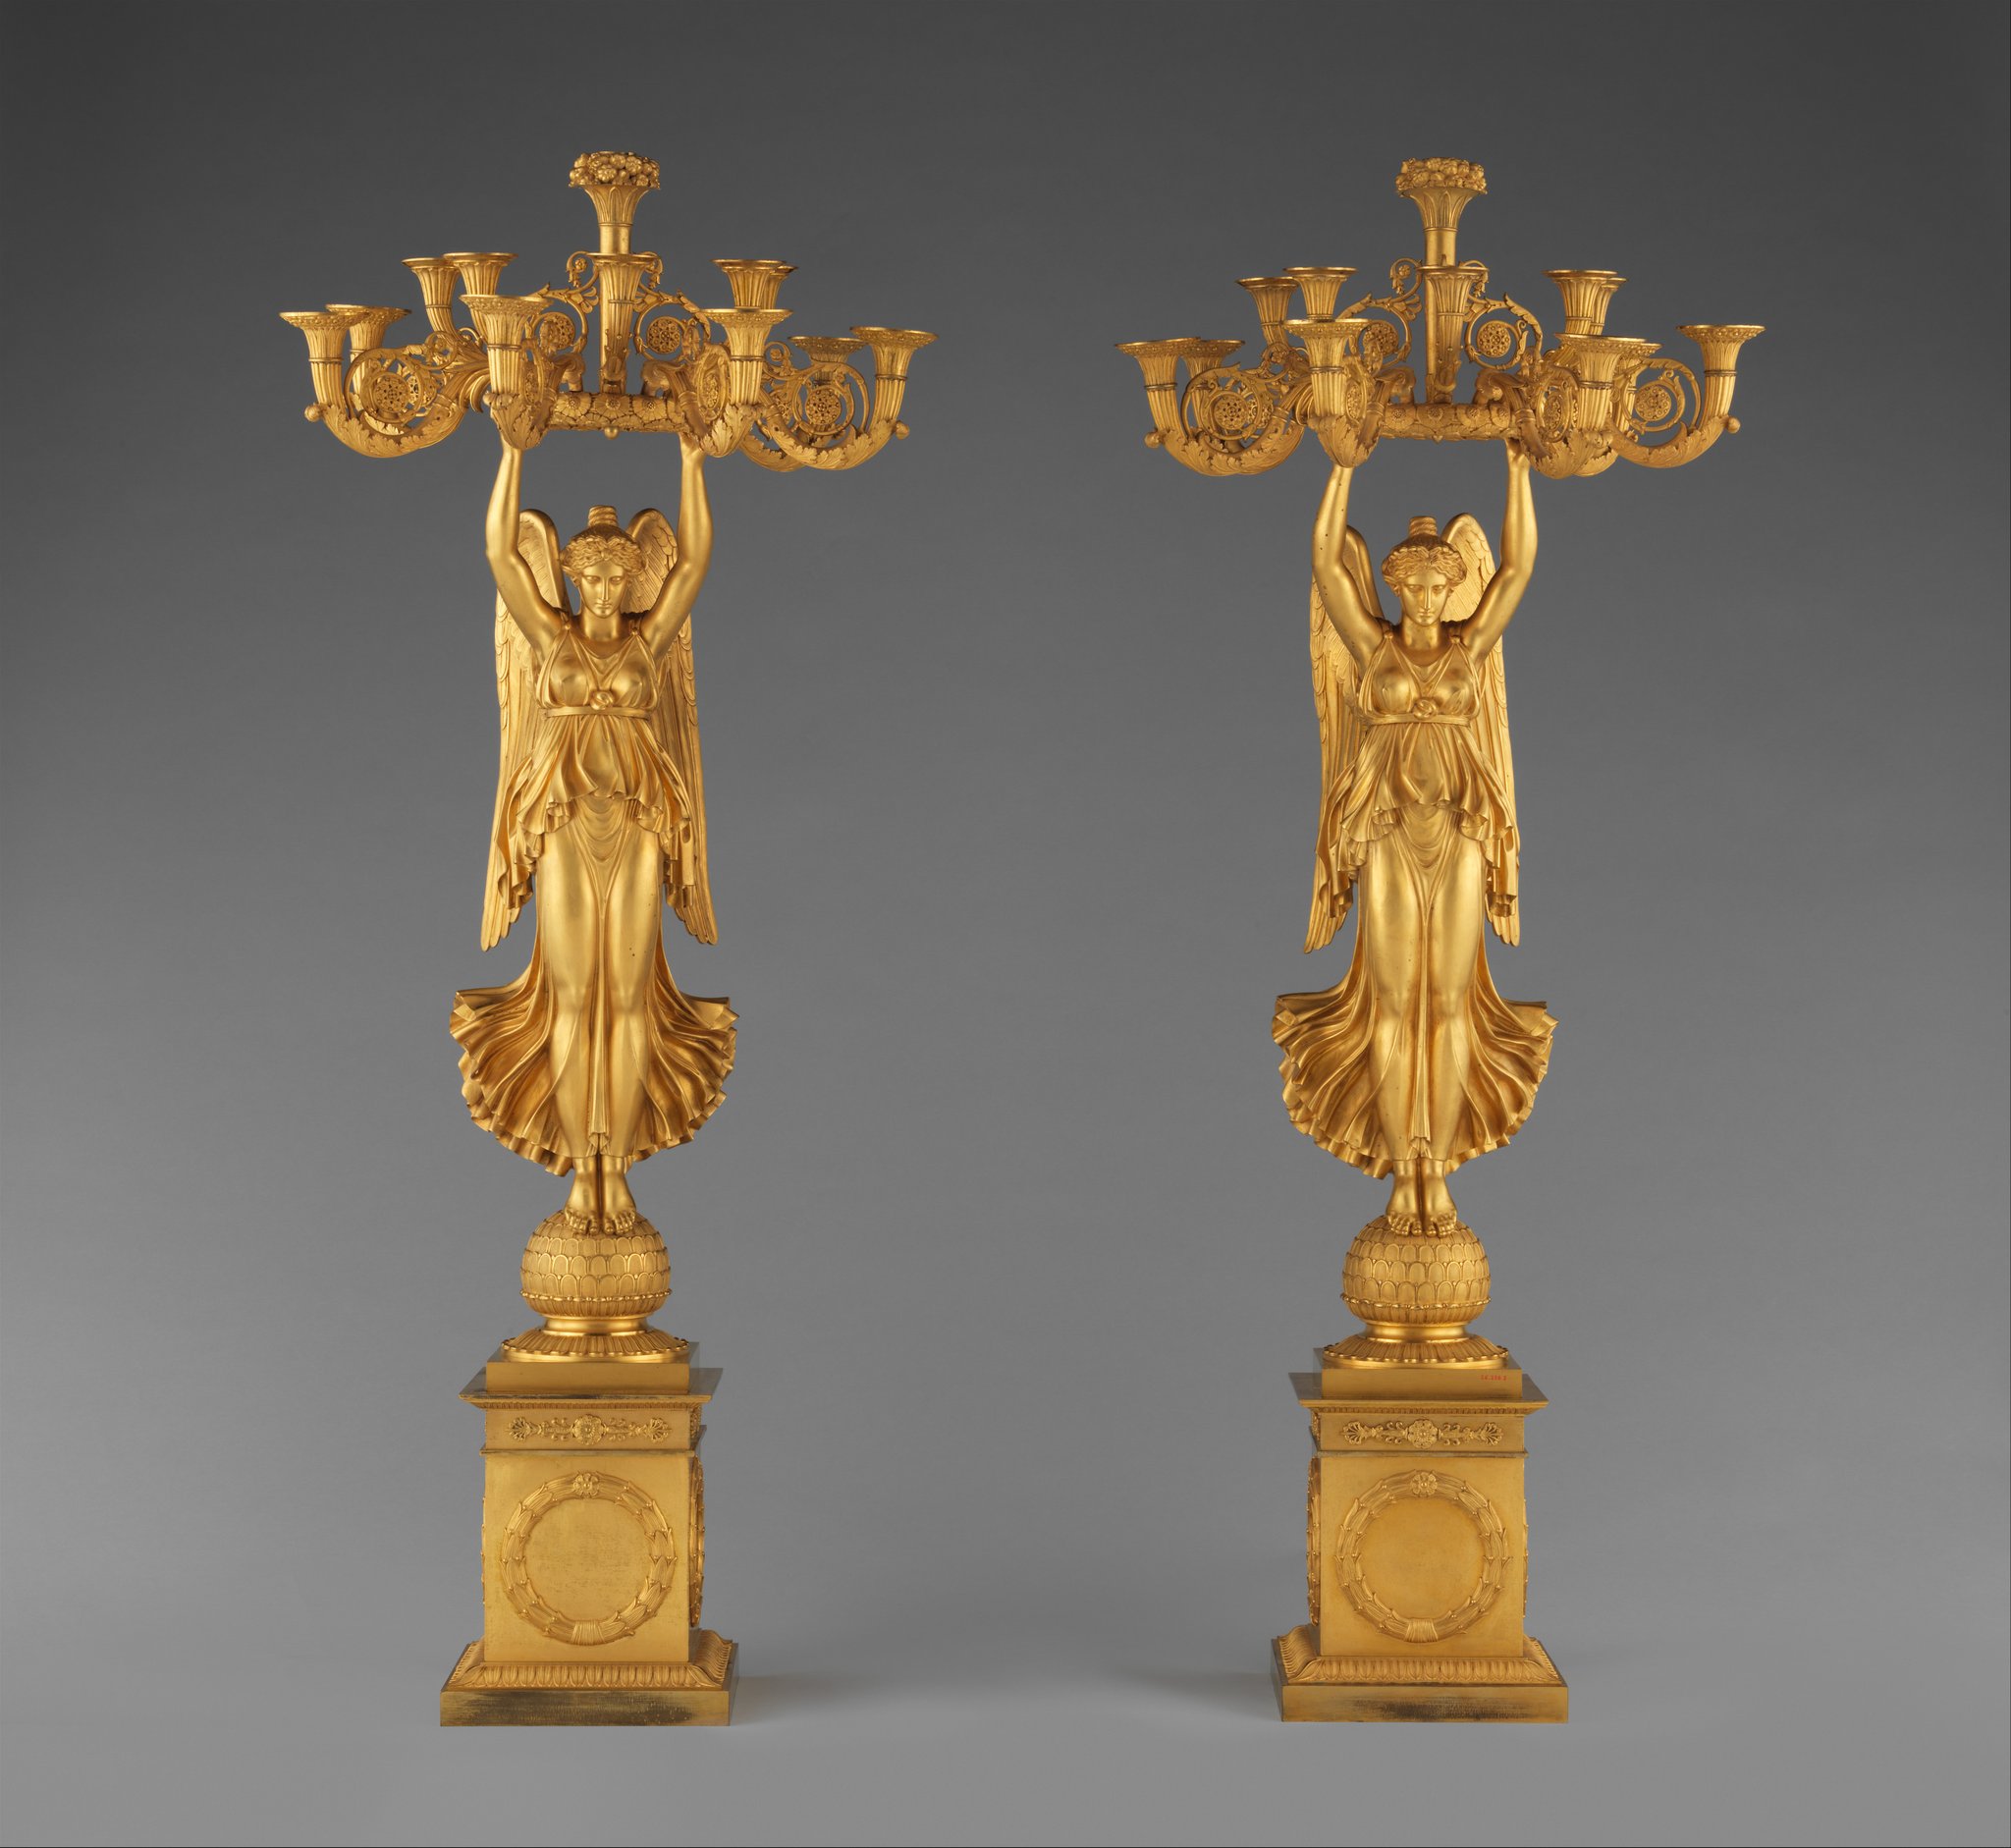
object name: candelabrum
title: Pair of candelabra with Winged Victories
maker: pierre philippe thomire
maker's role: artist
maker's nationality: french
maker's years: 1751-1843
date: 1810-1815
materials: gilt bronze